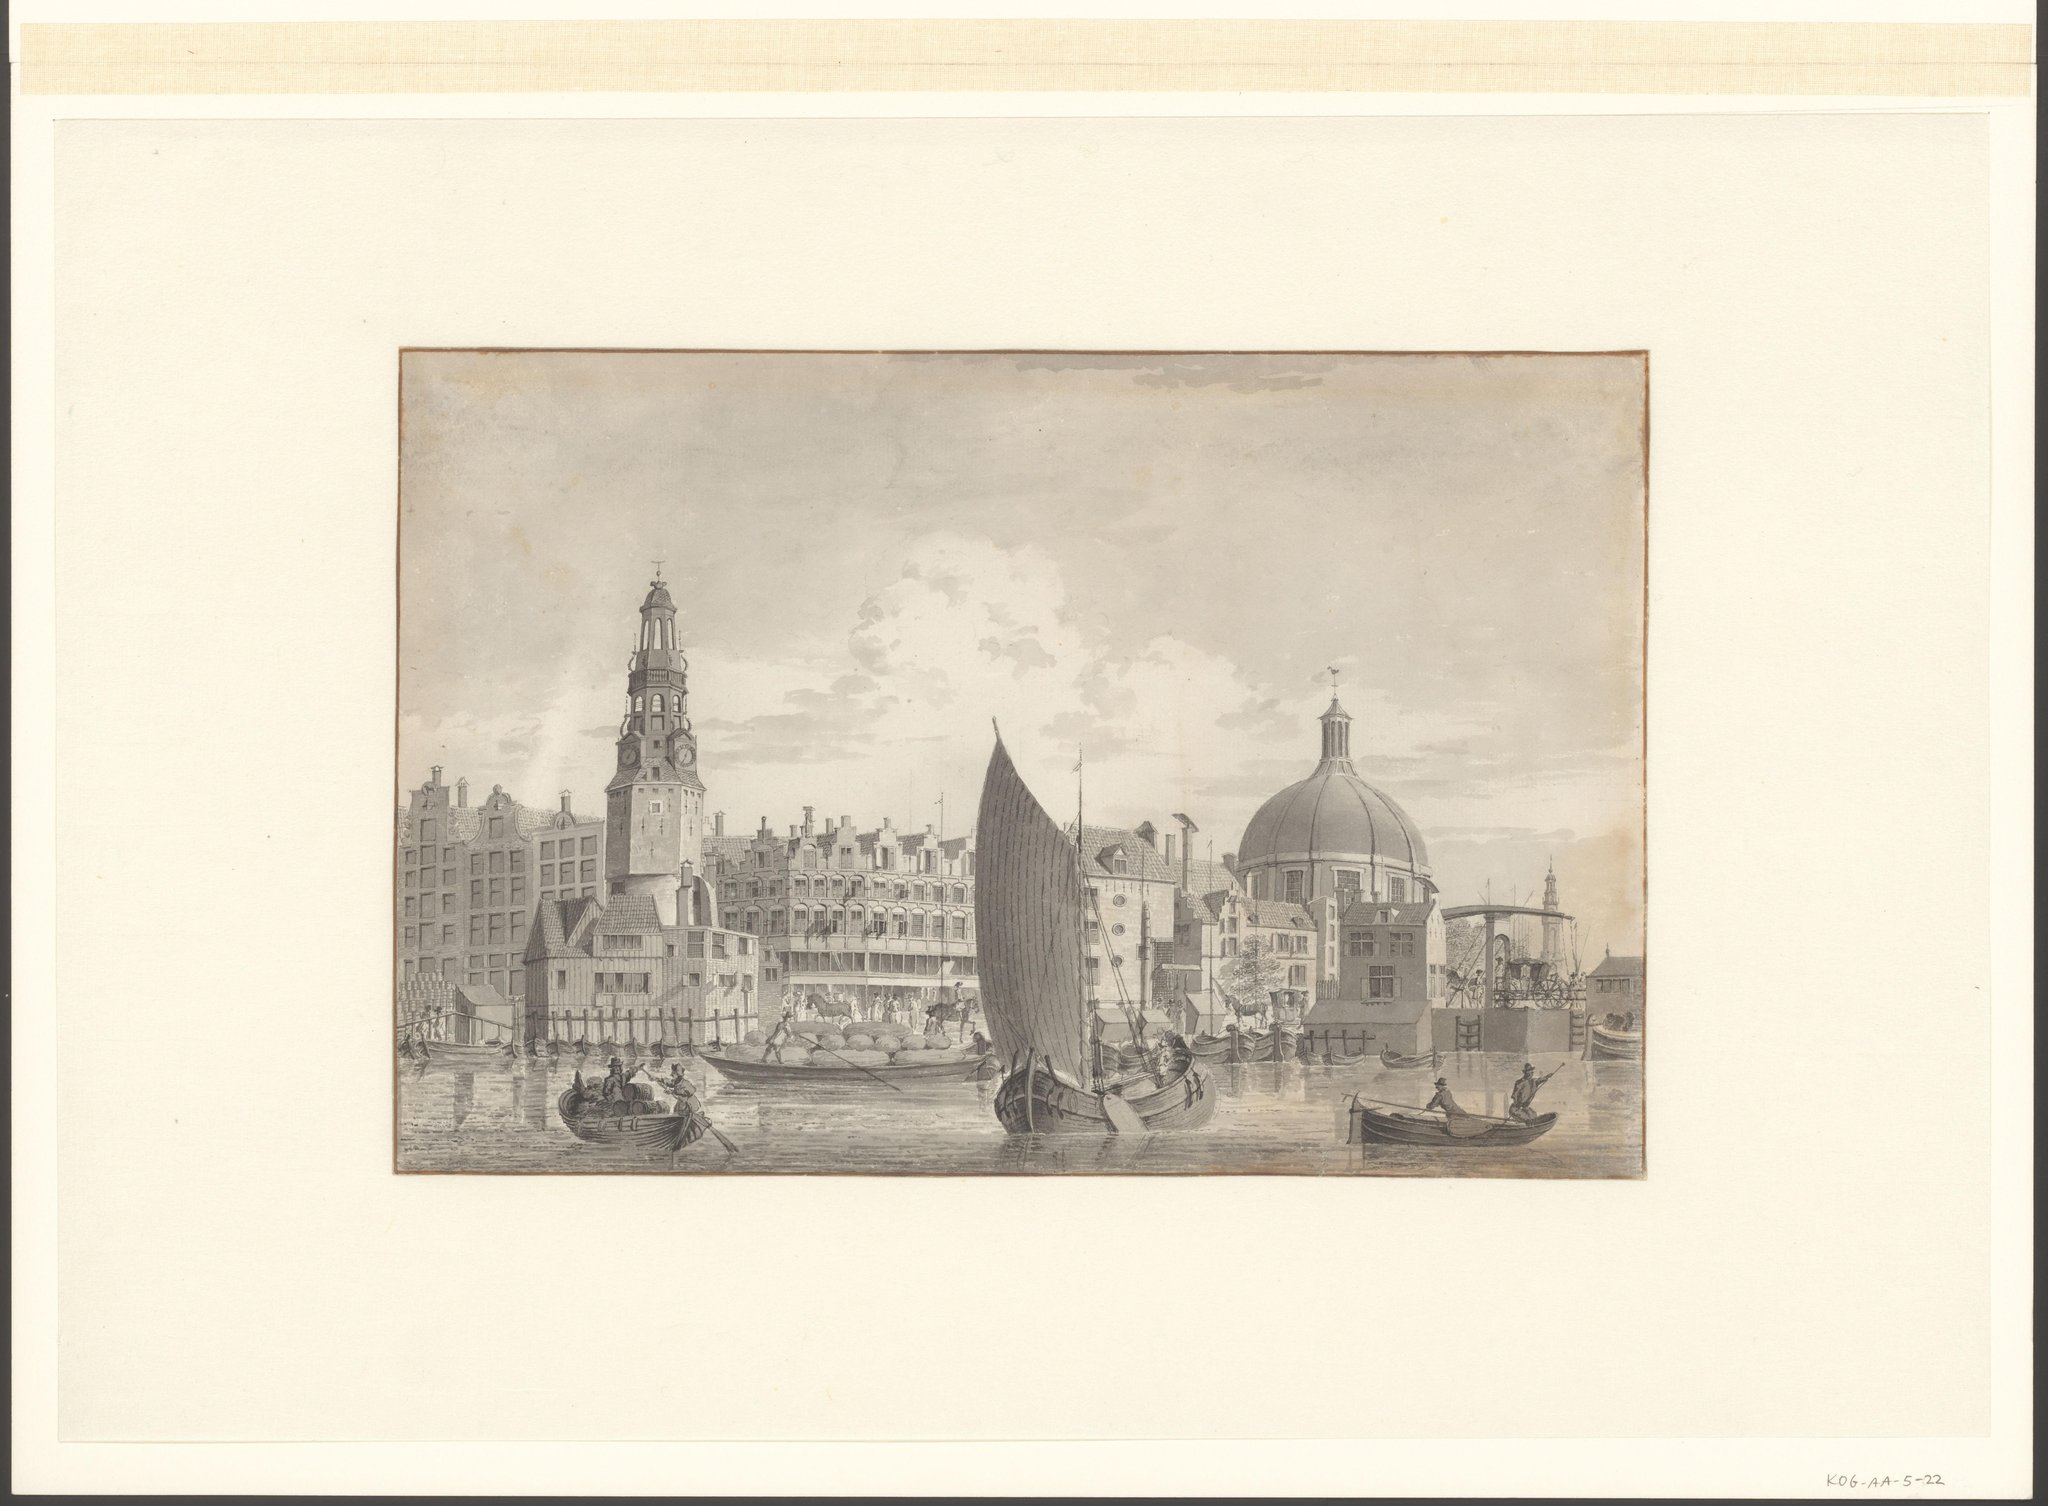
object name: drawing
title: Gezicht op de Haringpakkerstoren en de Ronde Lutherse Kerk vanaf het IJ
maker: Anonymous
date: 1750-1829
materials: ink, paper, pencil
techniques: brush, pen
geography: amsterdam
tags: tower, clock tower ~ monumental adornment, city-view in general; 'veduta', river, church (exterior)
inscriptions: inscription: ‘De haringpakkers Tooren & / nieuwe lutersche kerk’, number: ‘11’, number: ‘54’